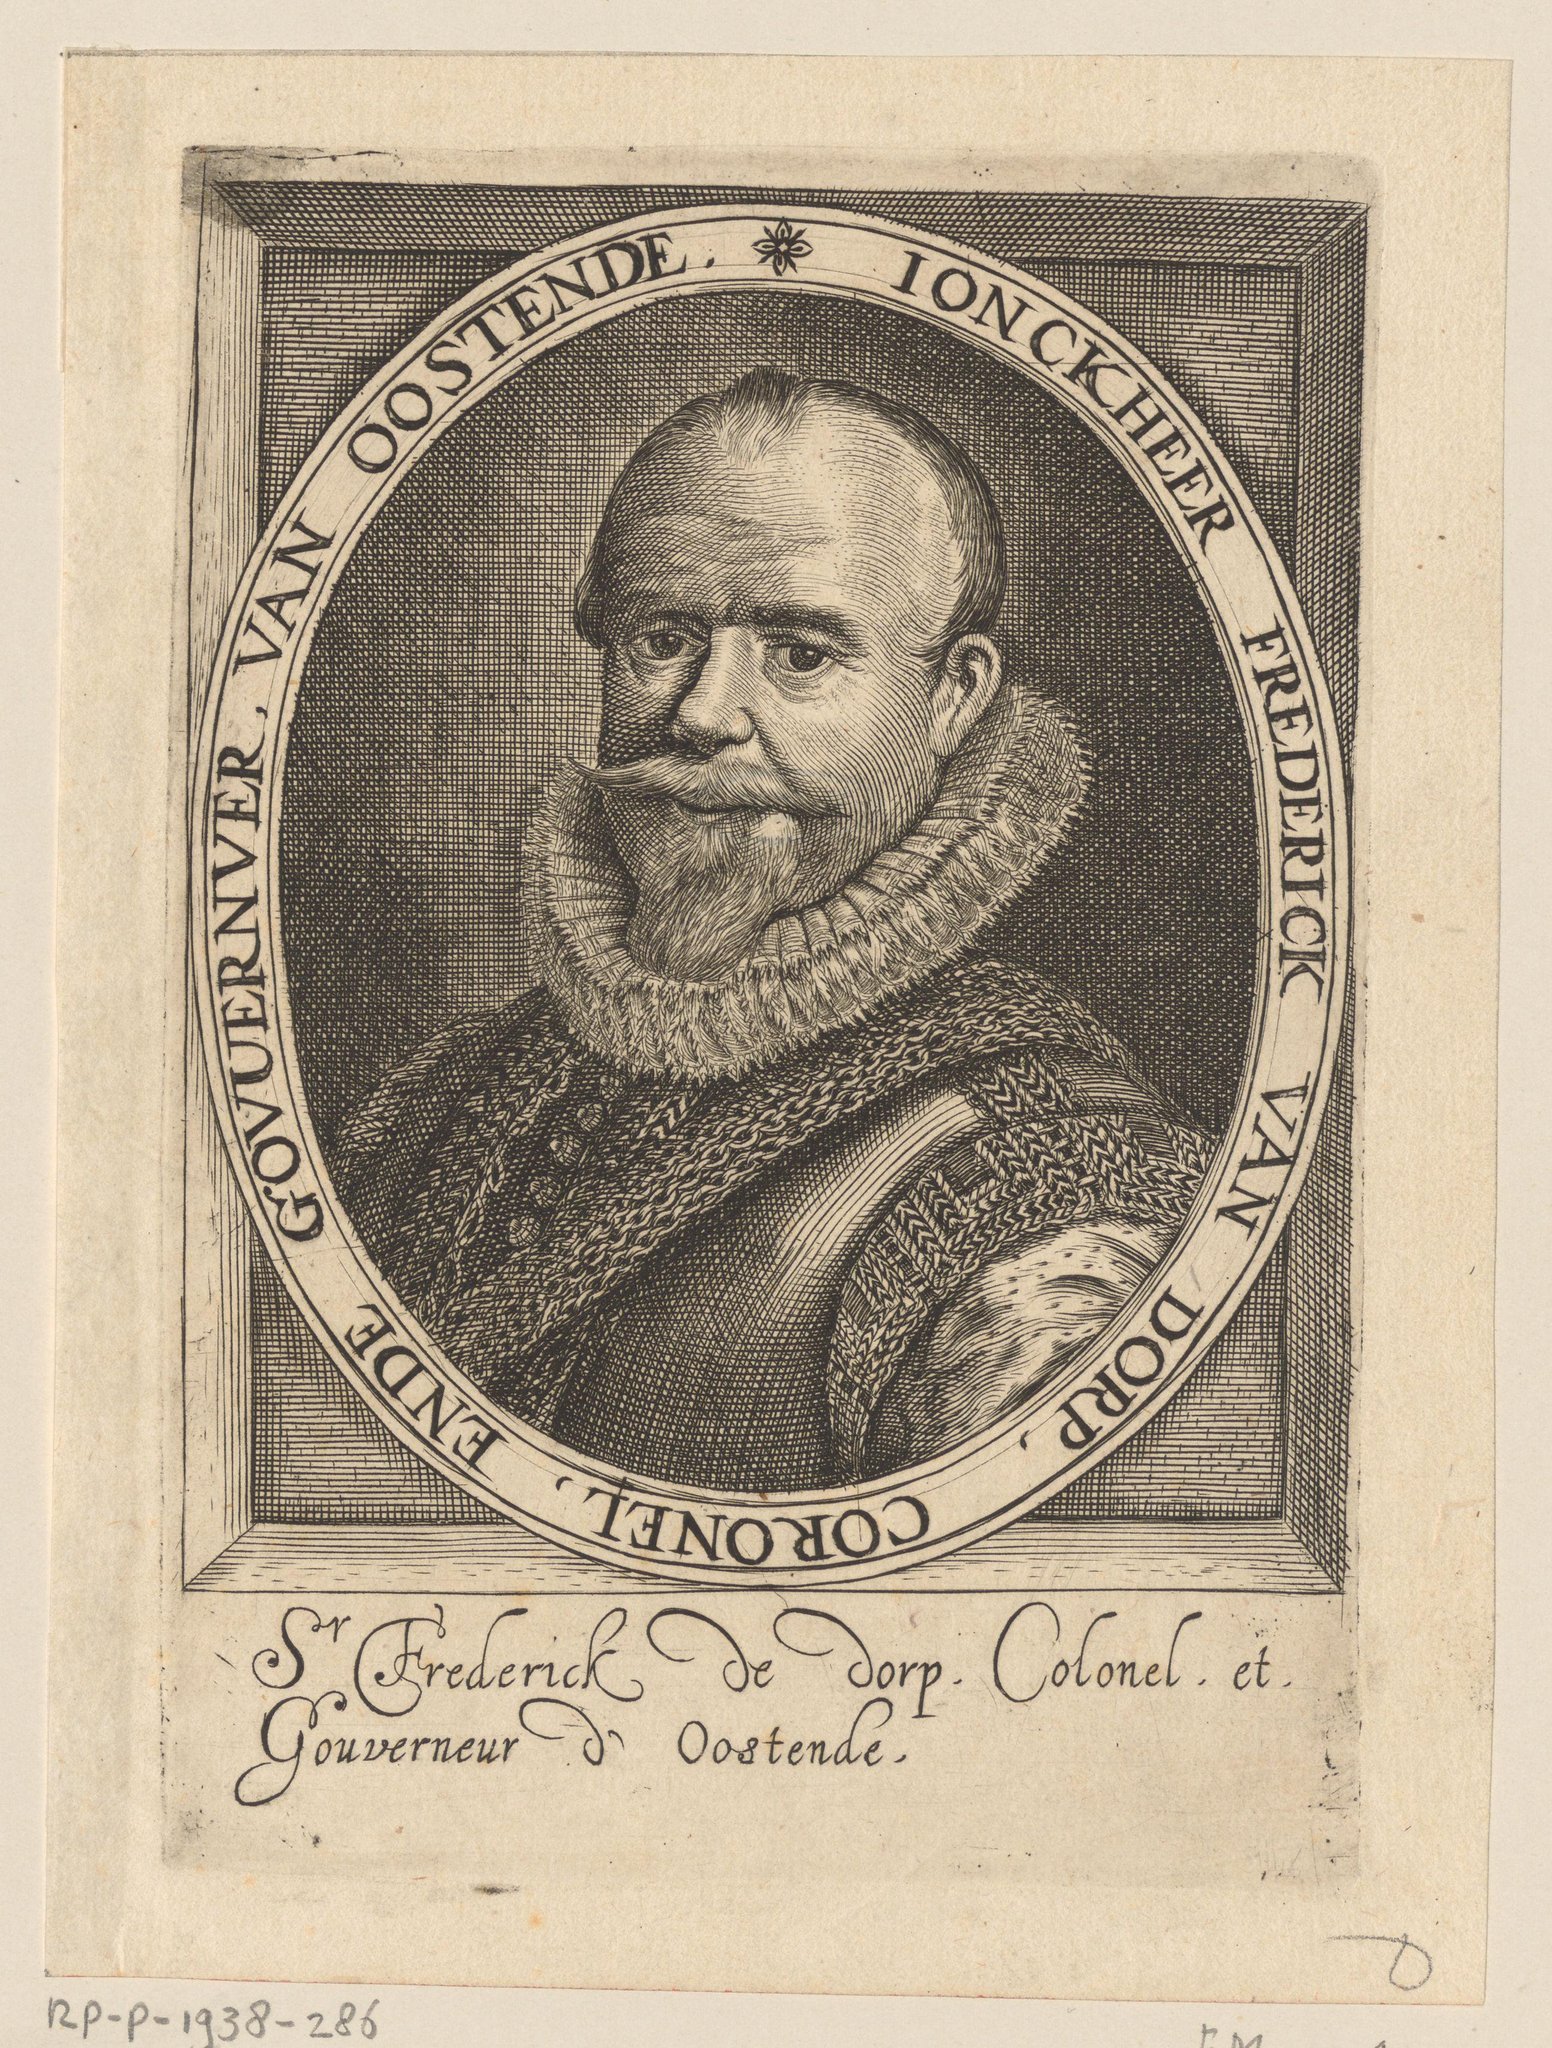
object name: print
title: Portret van Frederik van Dorp, gouverneur van Oostende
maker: Anonymous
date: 1621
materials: paper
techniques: engraving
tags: historical persons, governor, etc. of province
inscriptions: collector's mark: Lugt 2228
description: Prent waarschijnlijk uit: Fleming, Philippe. Oostende. Vermaerde, gheweldighe, lanckduyrighe ende bloedighe belegheringhe, bestorminghe ende stoute aenvallen (...). Den Haag: Aert Meuris, 1621.